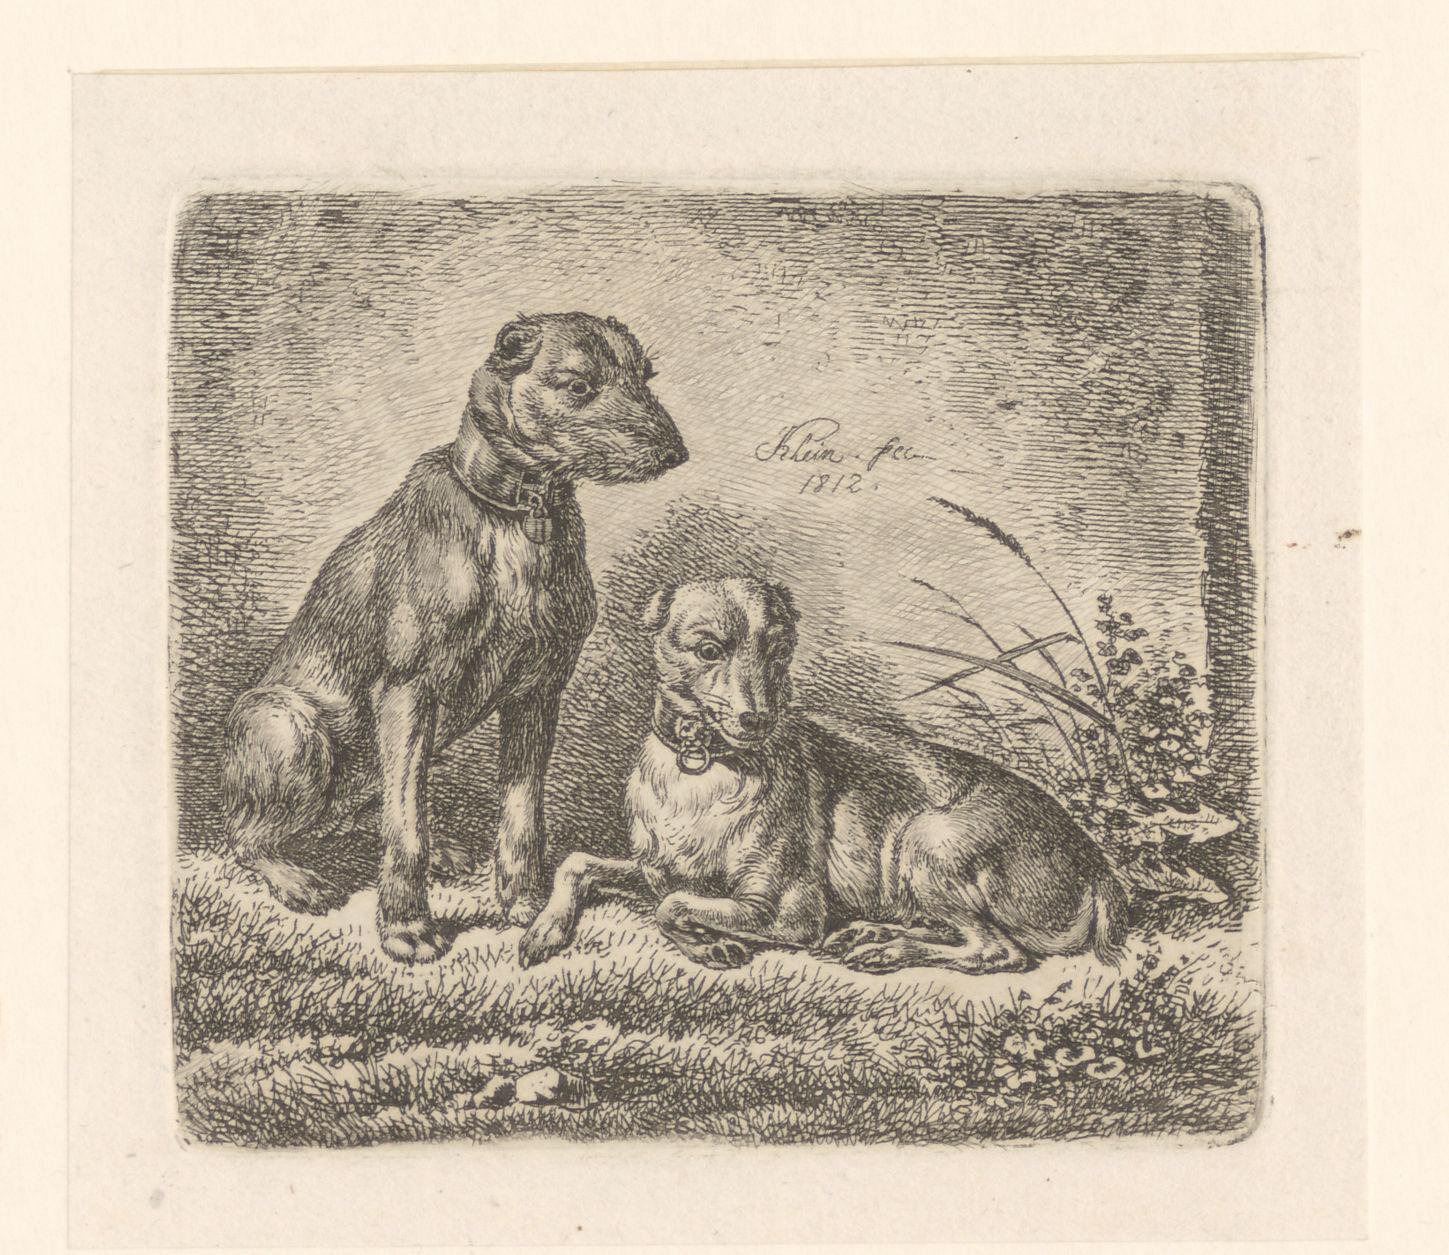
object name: print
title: Twee zittende honden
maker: johann adam klein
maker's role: draughtsman, print maker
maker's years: 1792-1875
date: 1812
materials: paper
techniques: etching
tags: dog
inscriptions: collector's mark: Lugt 2228